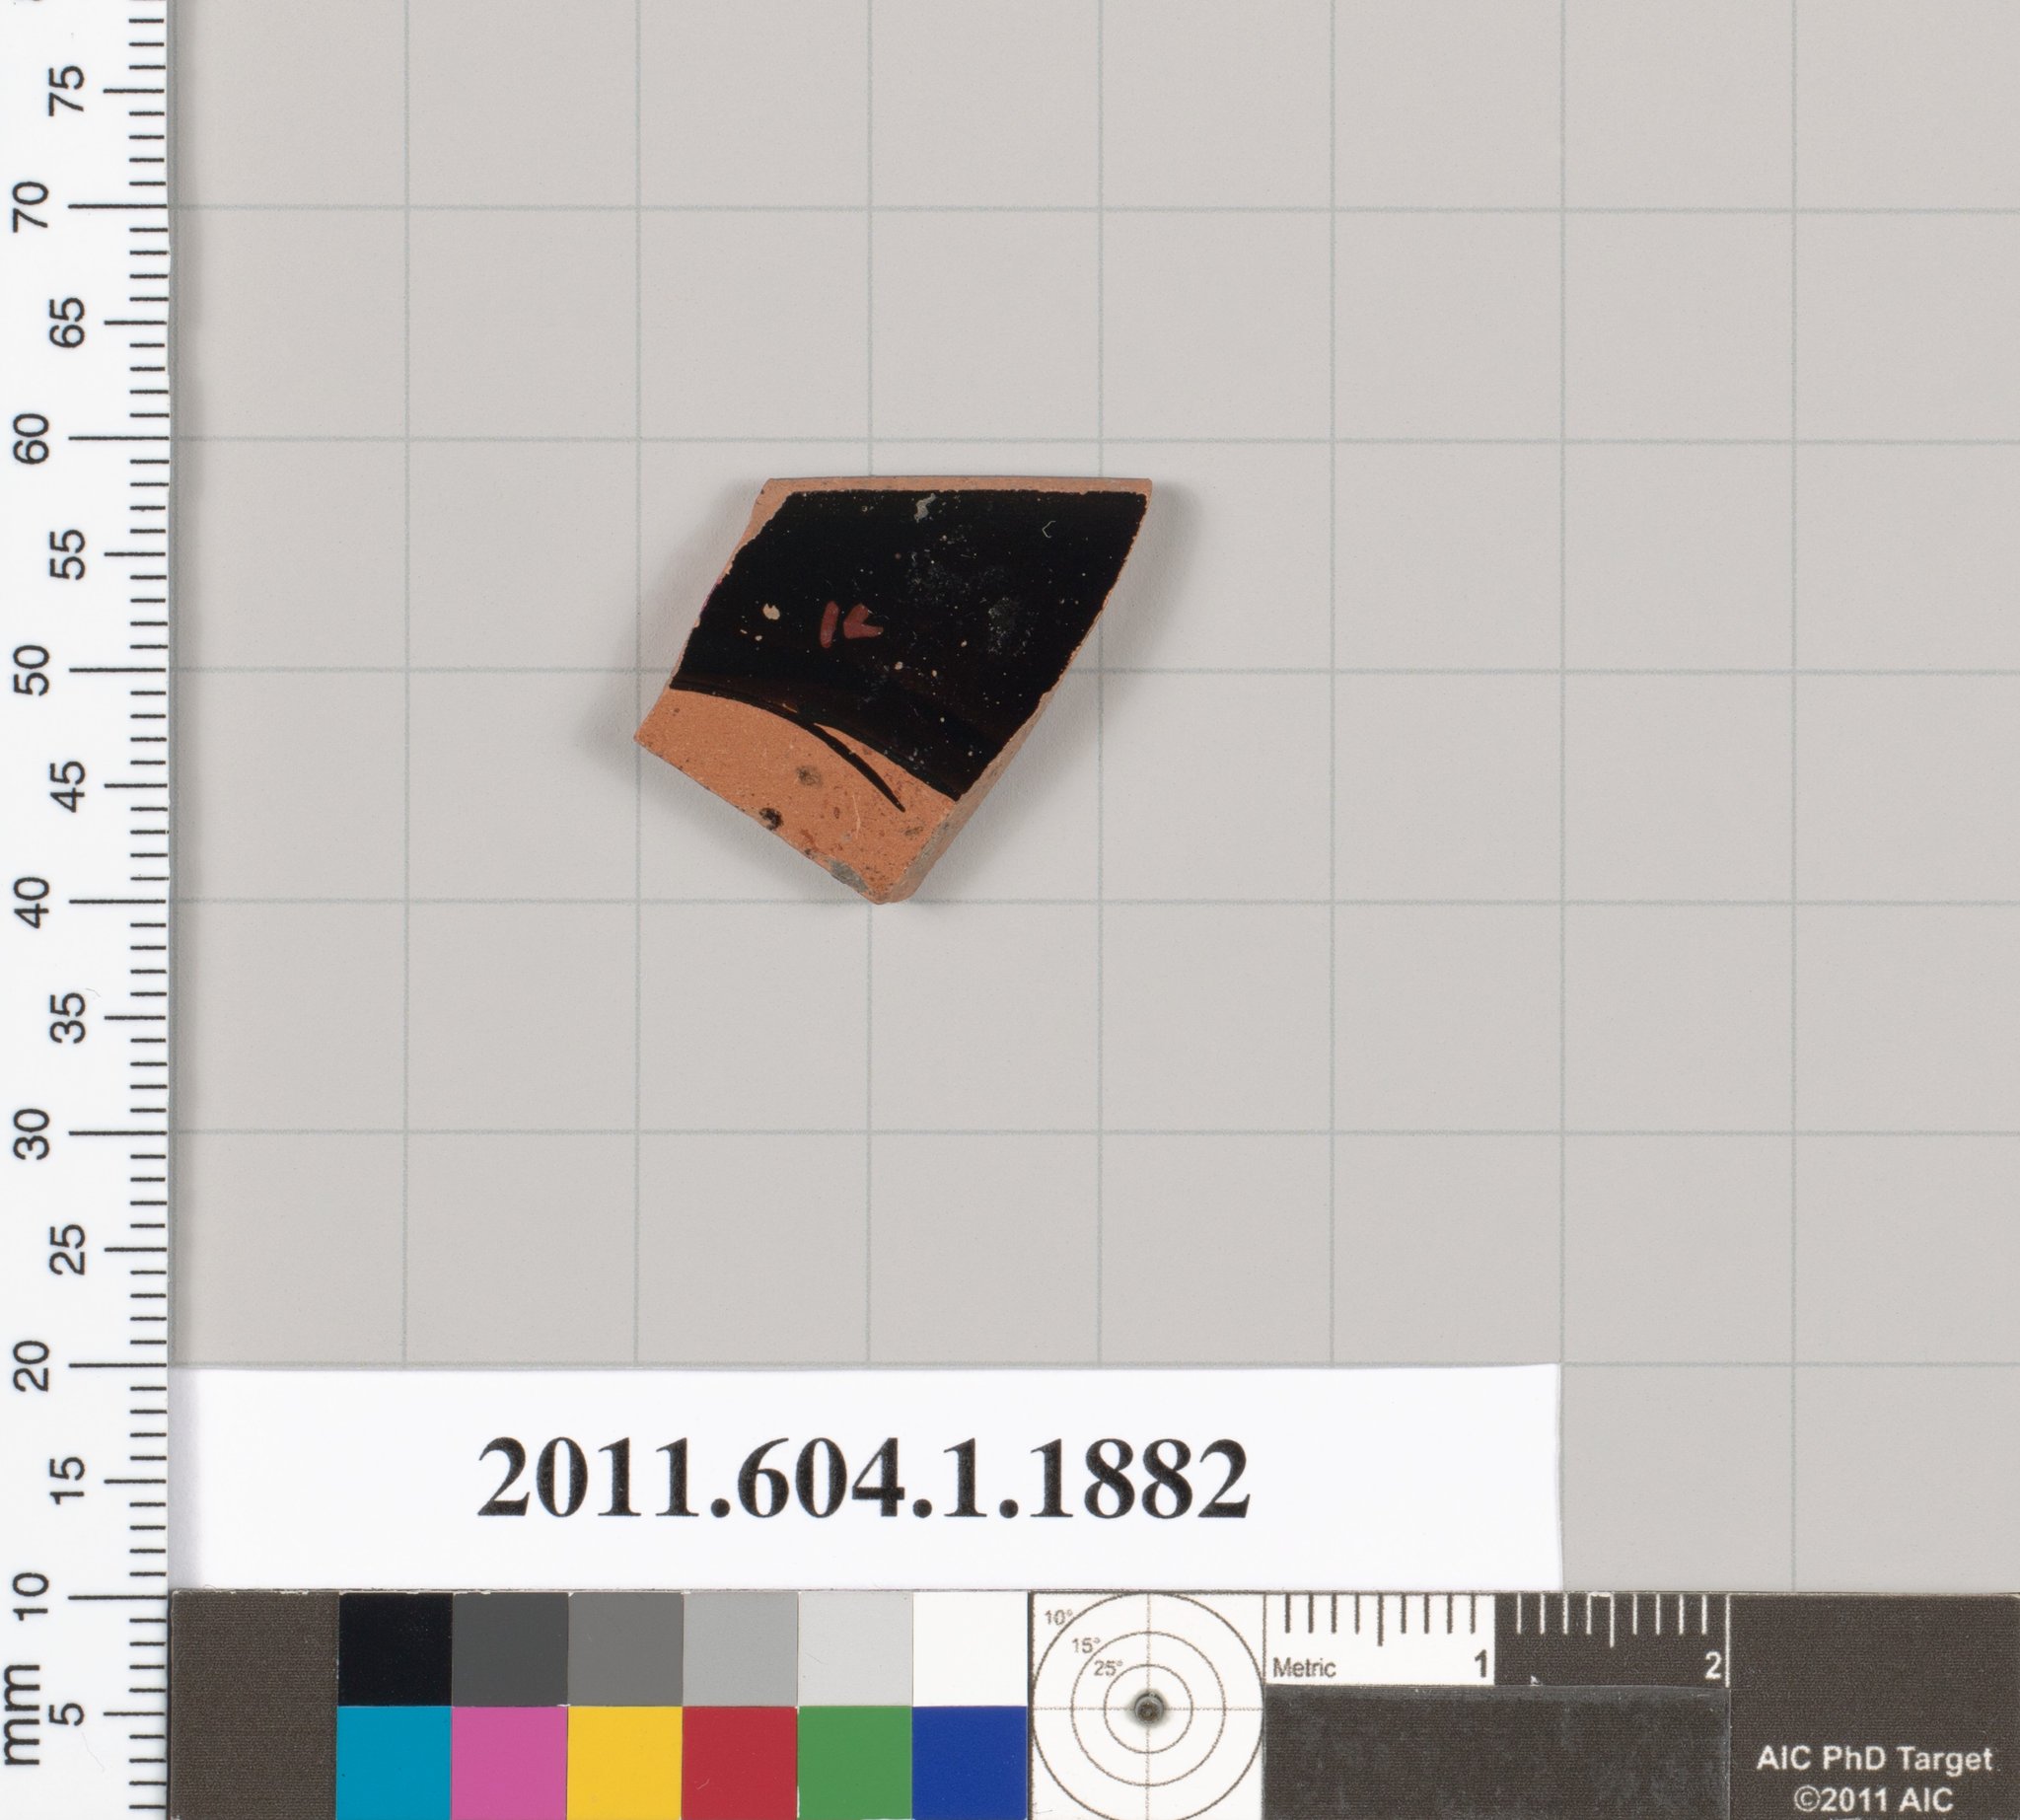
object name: kylix fragment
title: Terracotta rim fragment of a kylix (drinking cup)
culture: greek, attic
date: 475-451 BCE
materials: terracotta